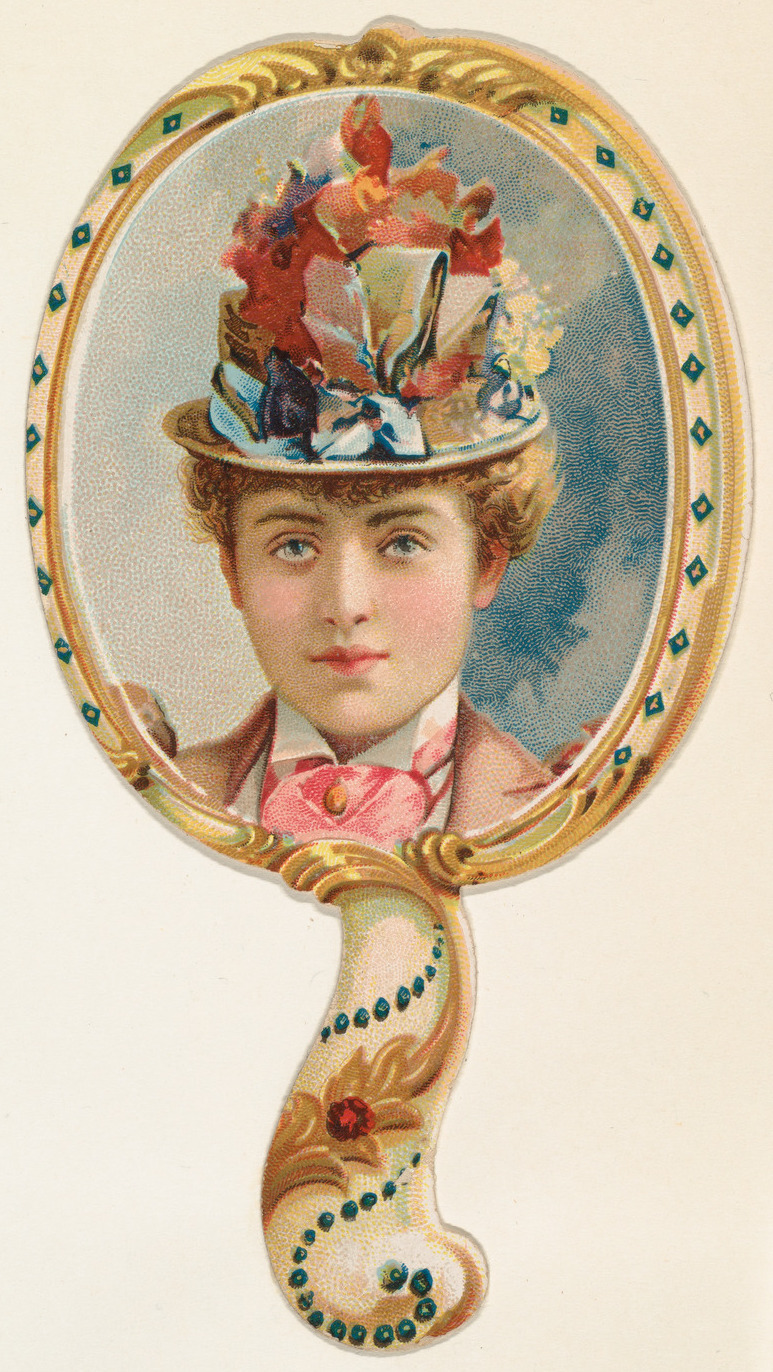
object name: print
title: Hand mirror with woman in floral hat with blue ribbont, from the Novelties series (N122) issued by Gail & Ax Tobacco to promote Navy Long Cut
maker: gail & ax tobacco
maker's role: publisher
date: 1889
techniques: color lithograph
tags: women,mirrors